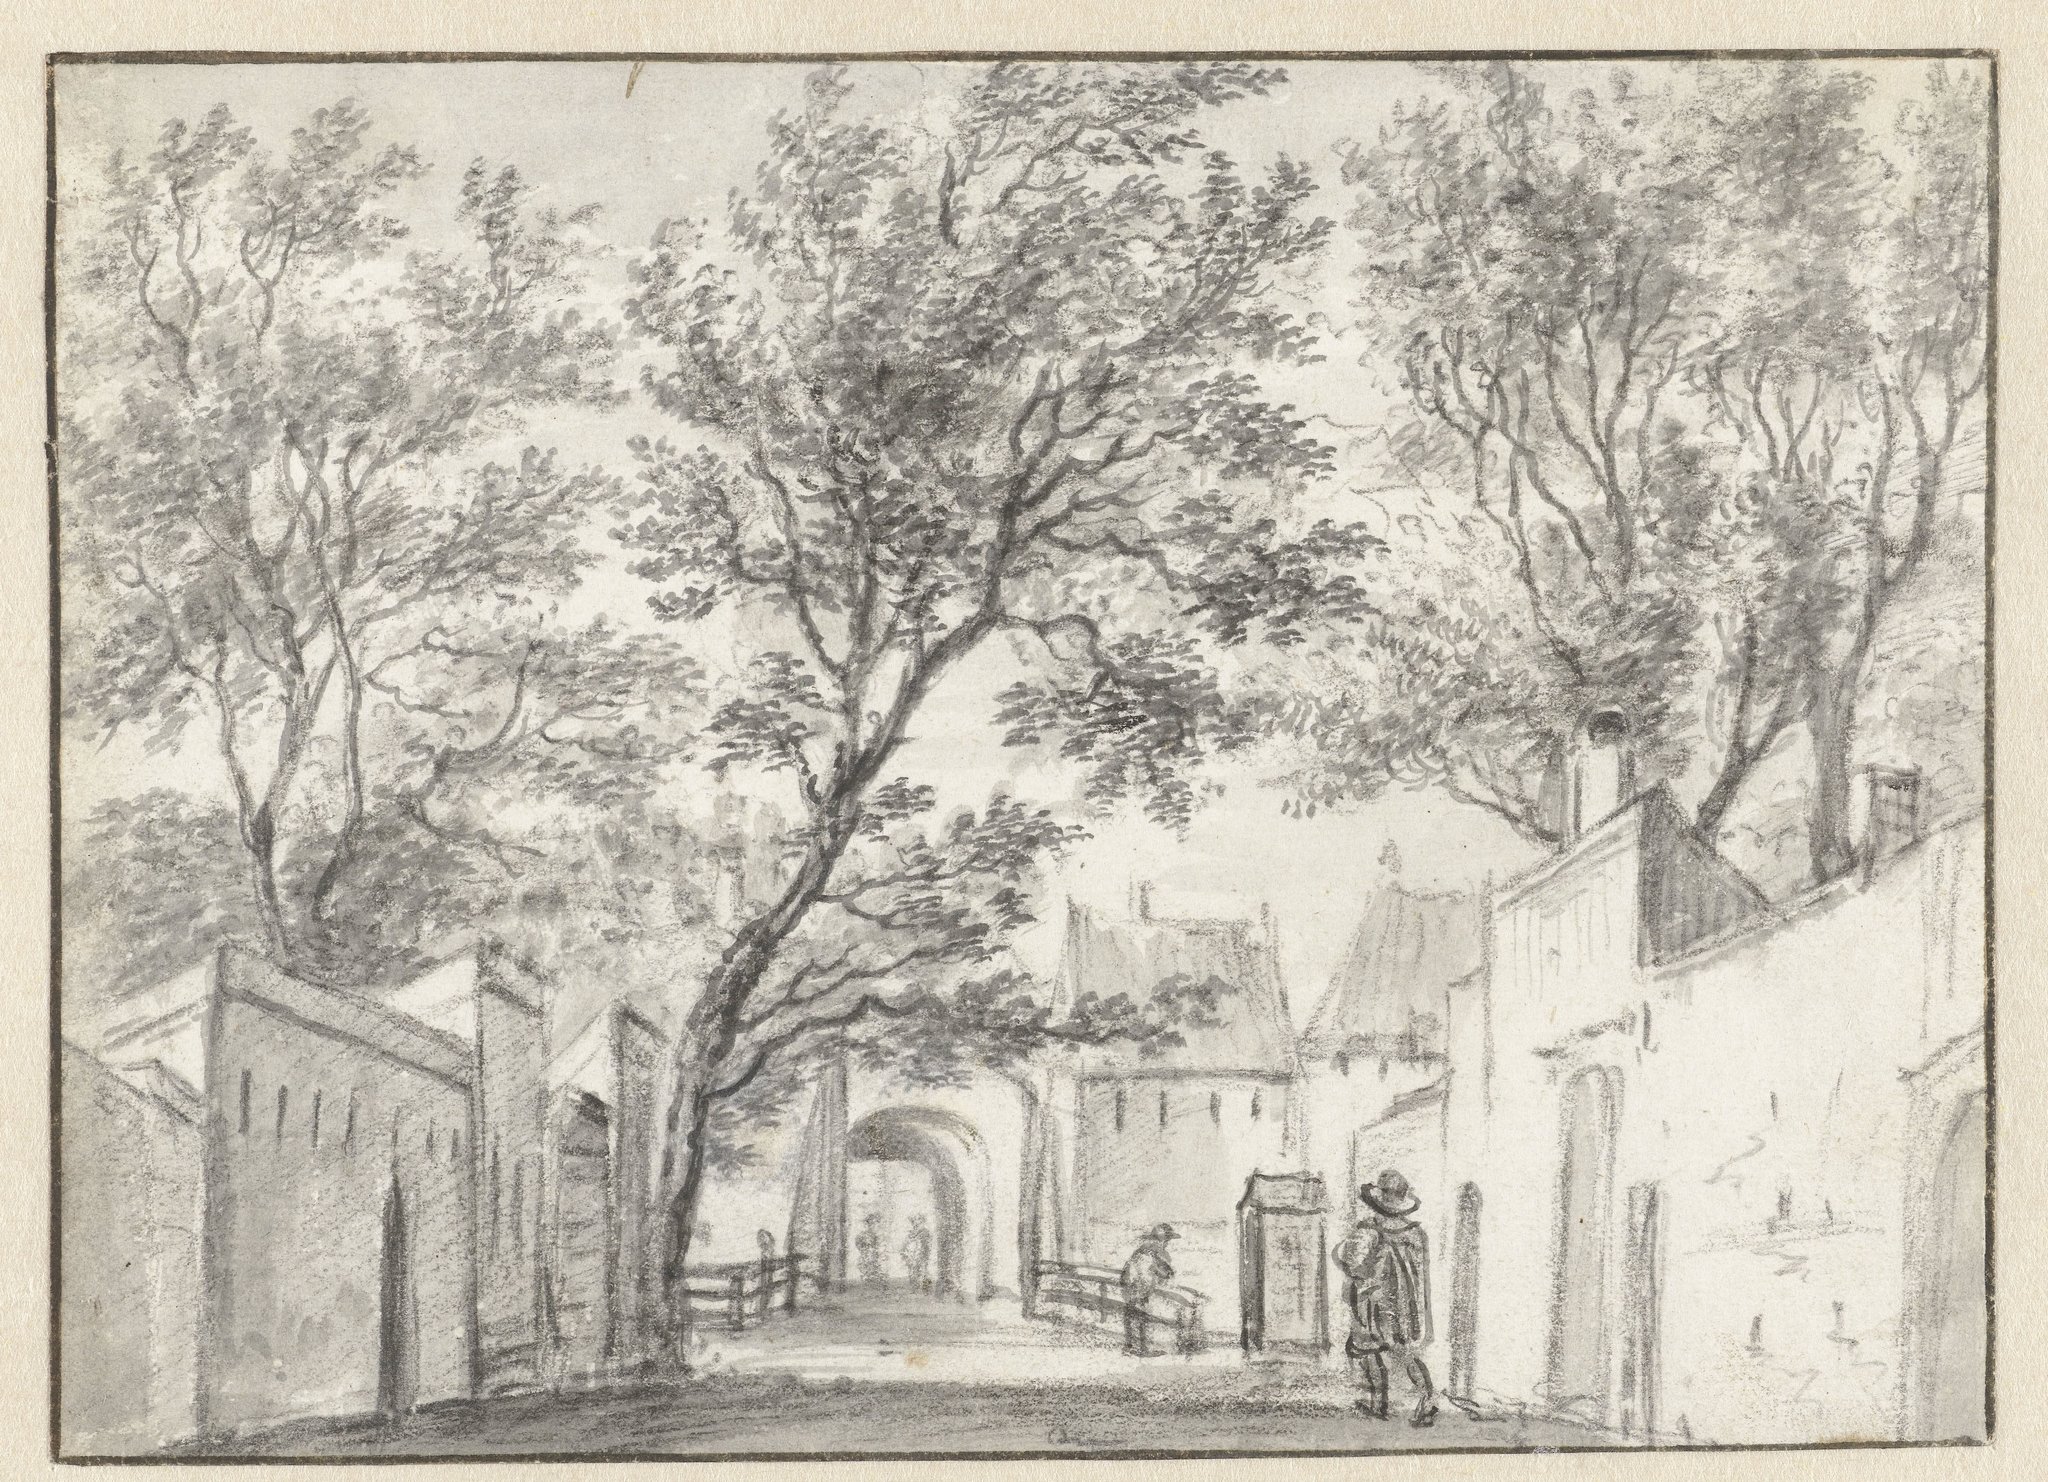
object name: drawing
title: Koepoort te Leiden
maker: anthonie waterloo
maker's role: draughtsman, painter, print maker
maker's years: 1609-1690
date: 1619-1690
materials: chalk, paper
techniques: brush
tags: city-gate, public road